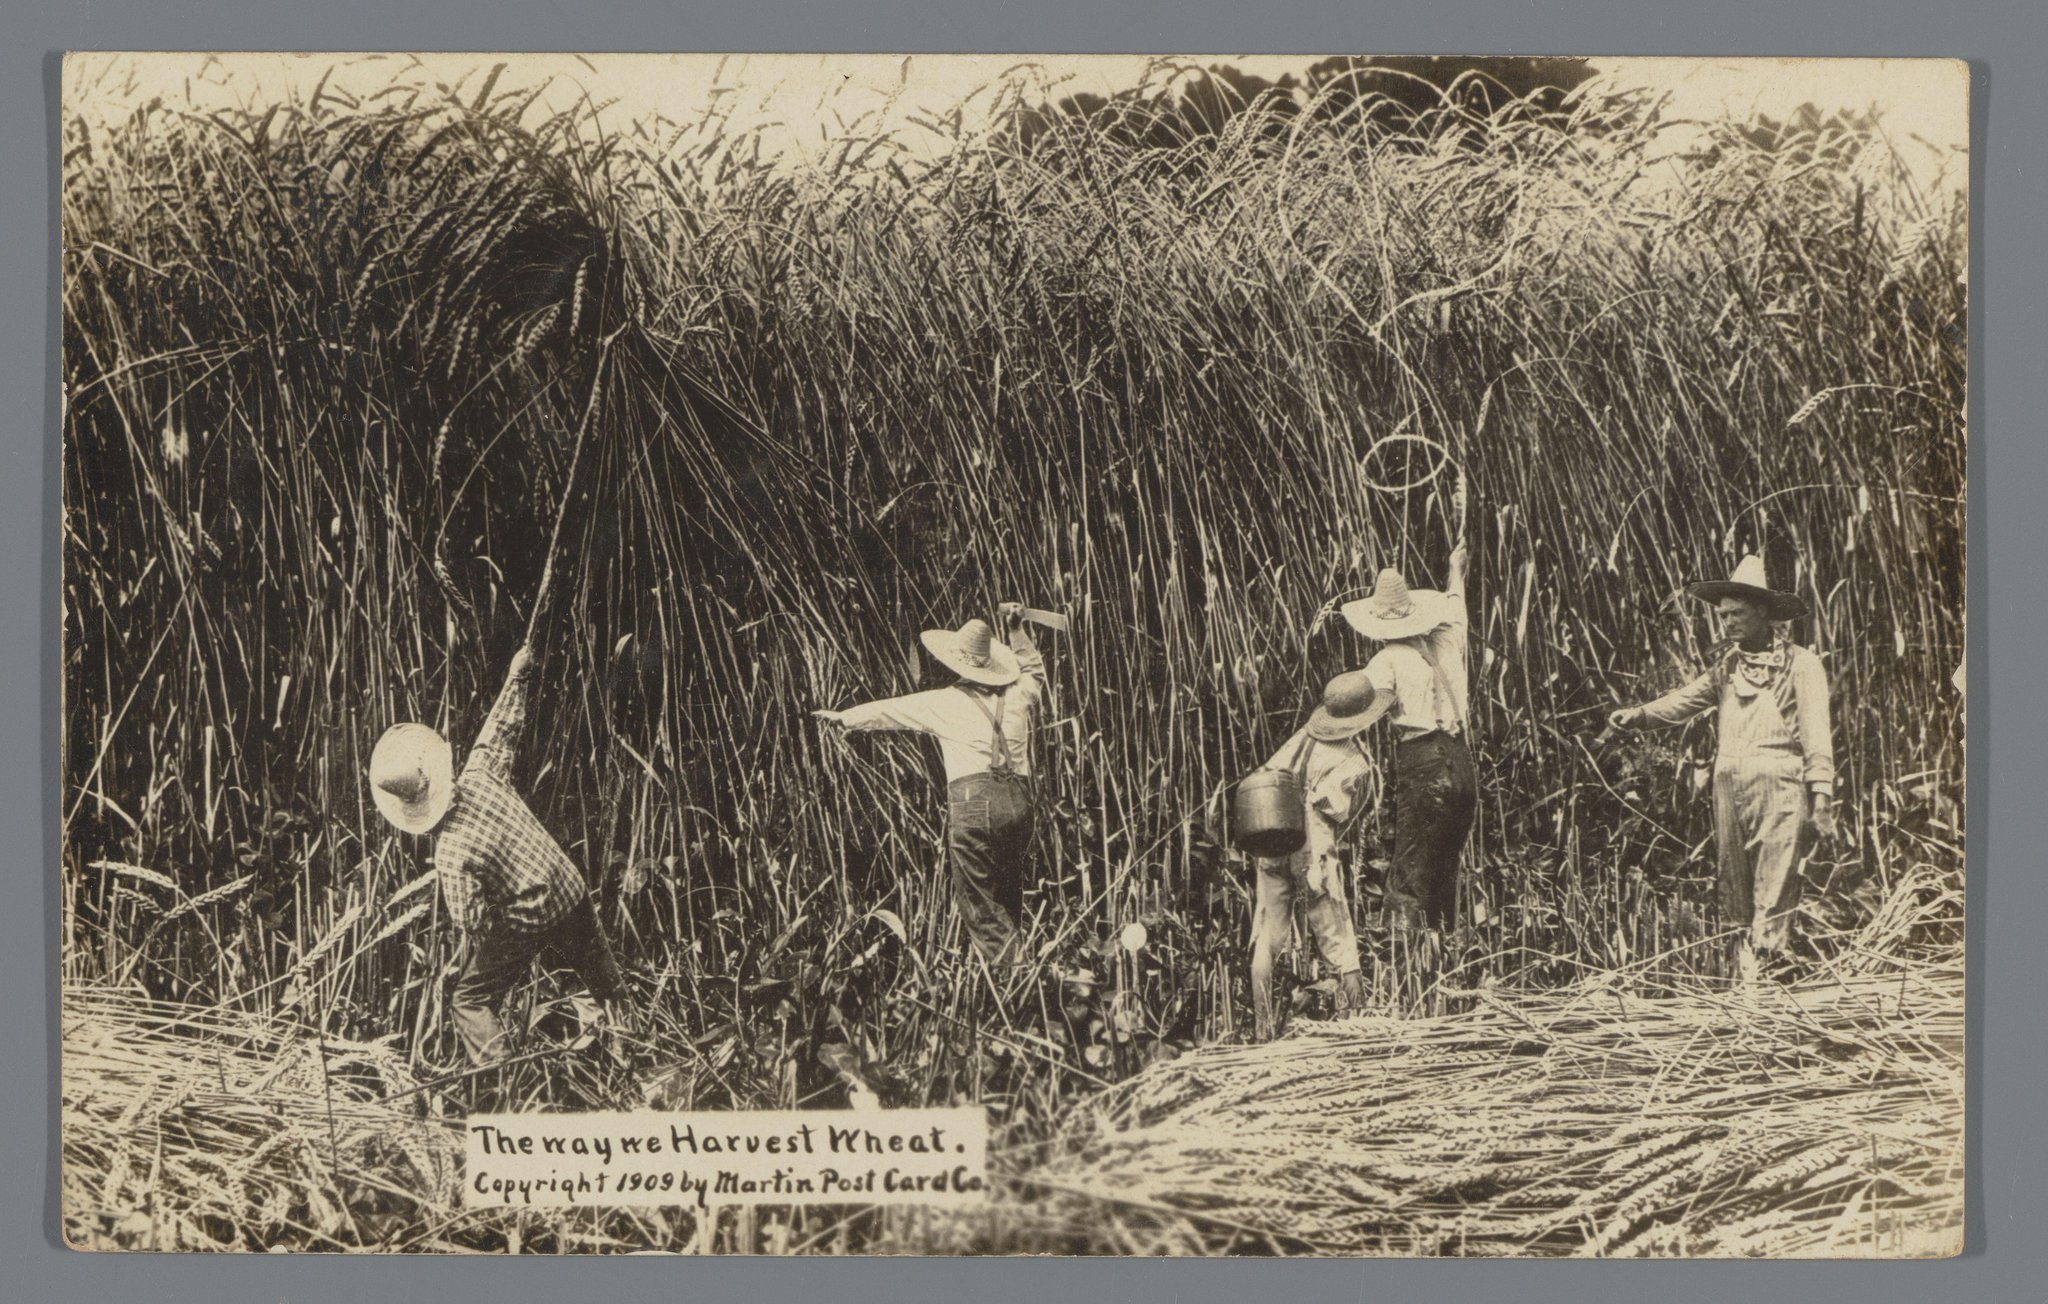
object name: ansichtkaart, prentbriefkaart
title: Prentbriefkaart met vijf mensen die reusachtig graan proberen te oogsten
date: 1909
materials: photographic support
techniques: gelatin silver print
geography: united states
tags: united states of america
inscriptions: inscription: ‘PUBLISHED BY / THE NORTH AMERICAN POST CARD CO. / KANSAS CITY, U. S. A.’, inscription: ‘The way we Harvest Wheat. / Copyright 1909 by Martin Post Card Co.’